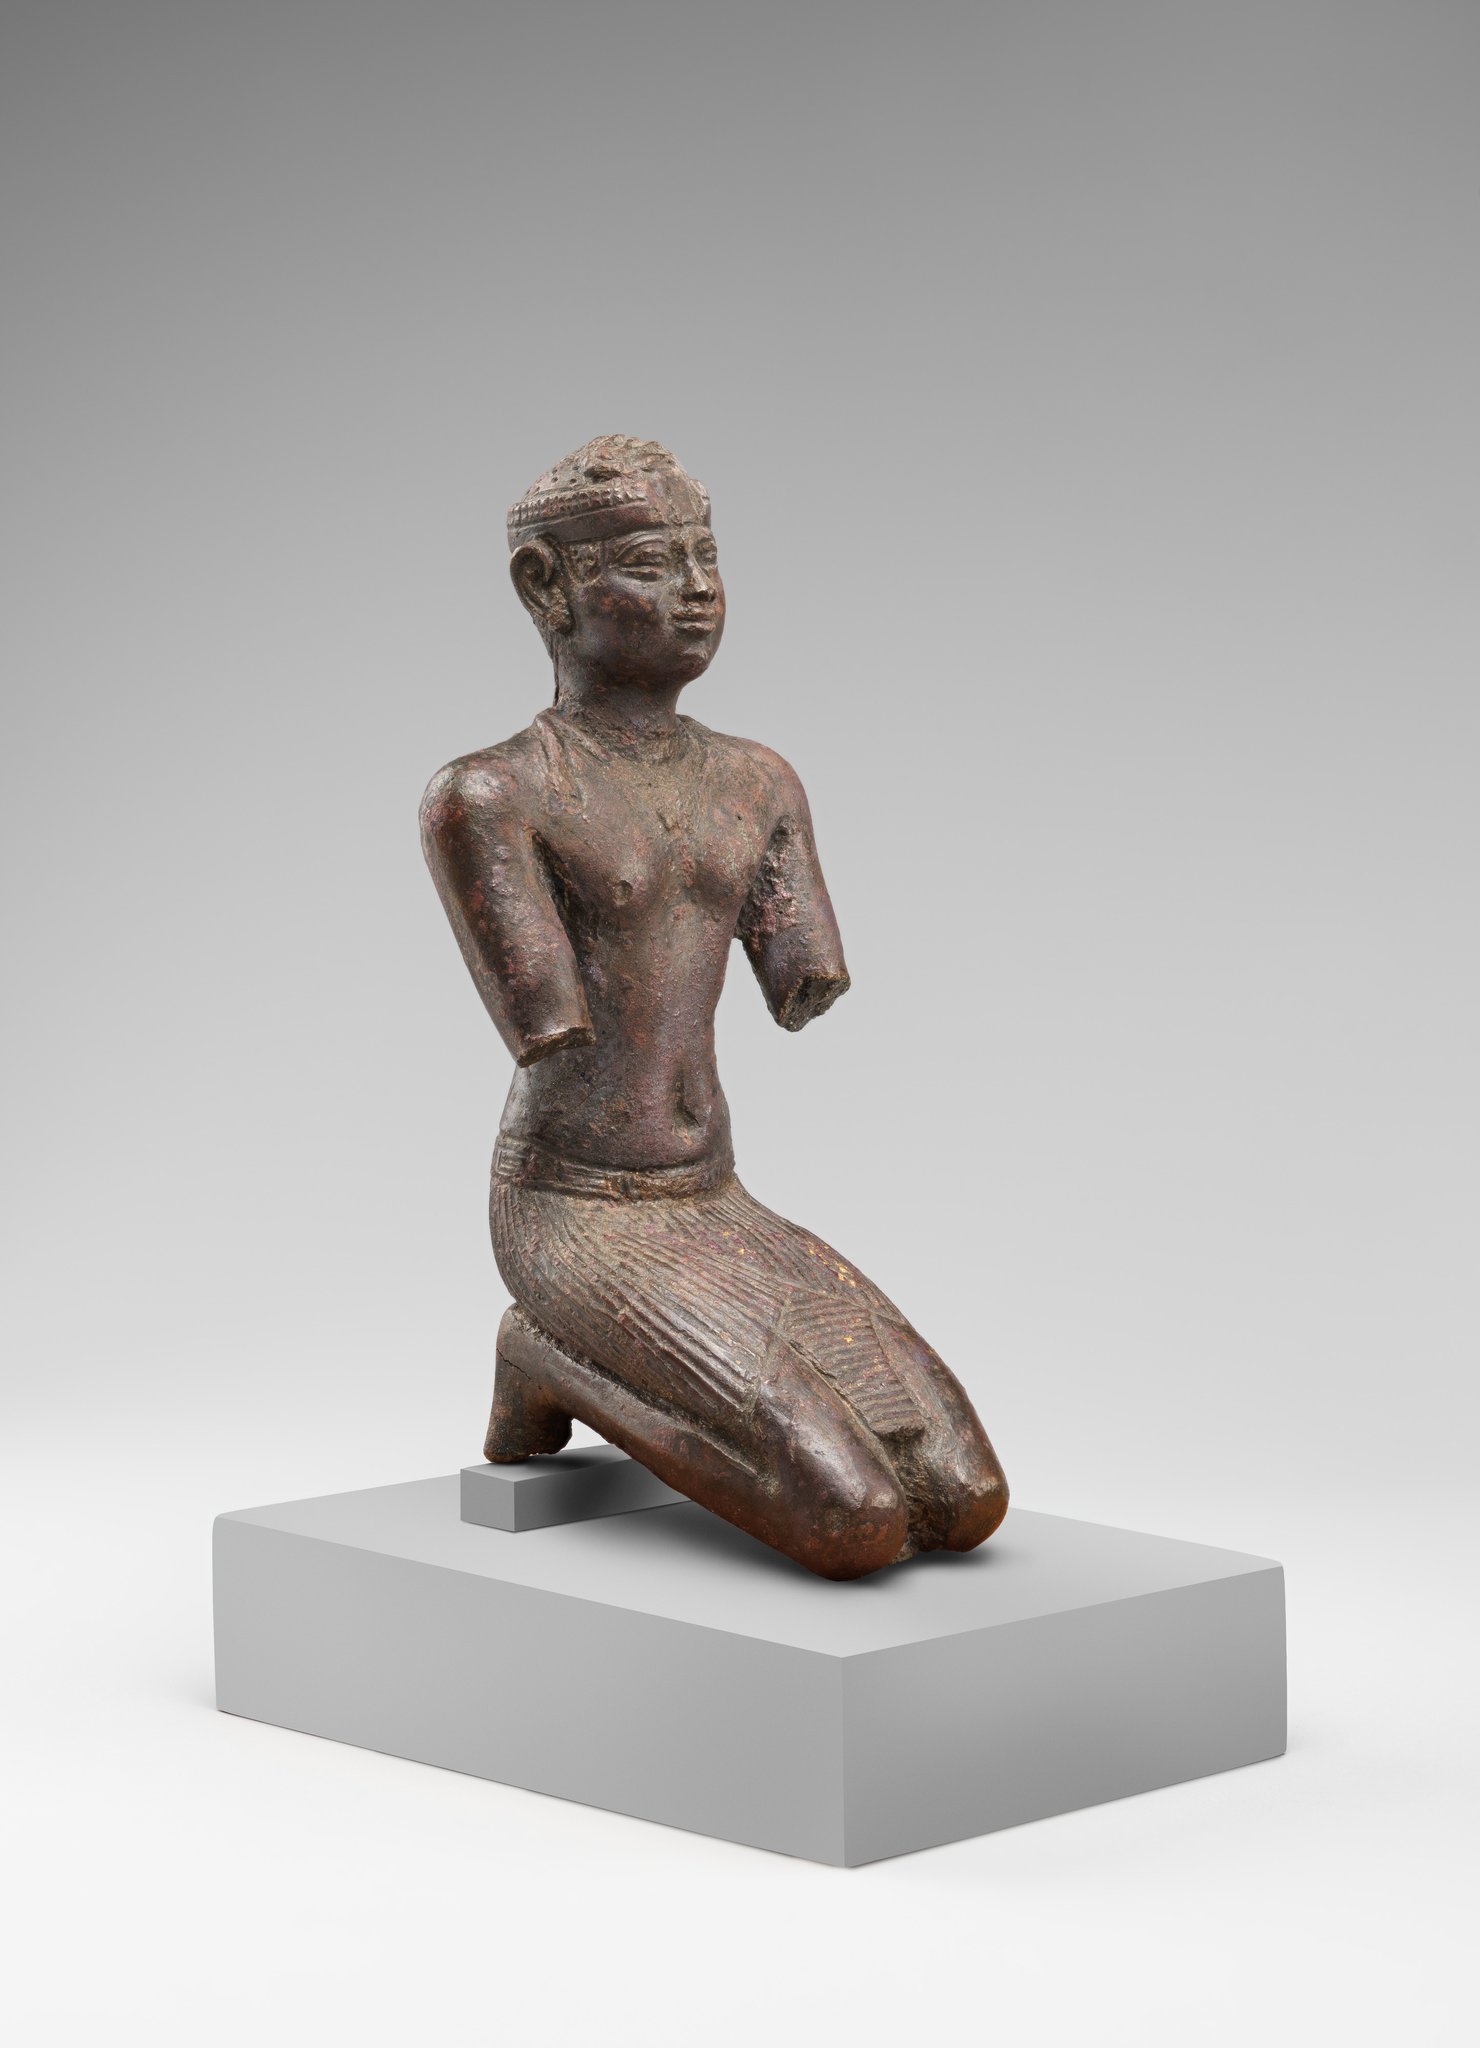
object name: statuette, kneeling king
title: Statue of a kneeling Kushite king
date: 733-664 BCE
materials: bronze, gold leaf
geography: egypt and sudan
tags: men